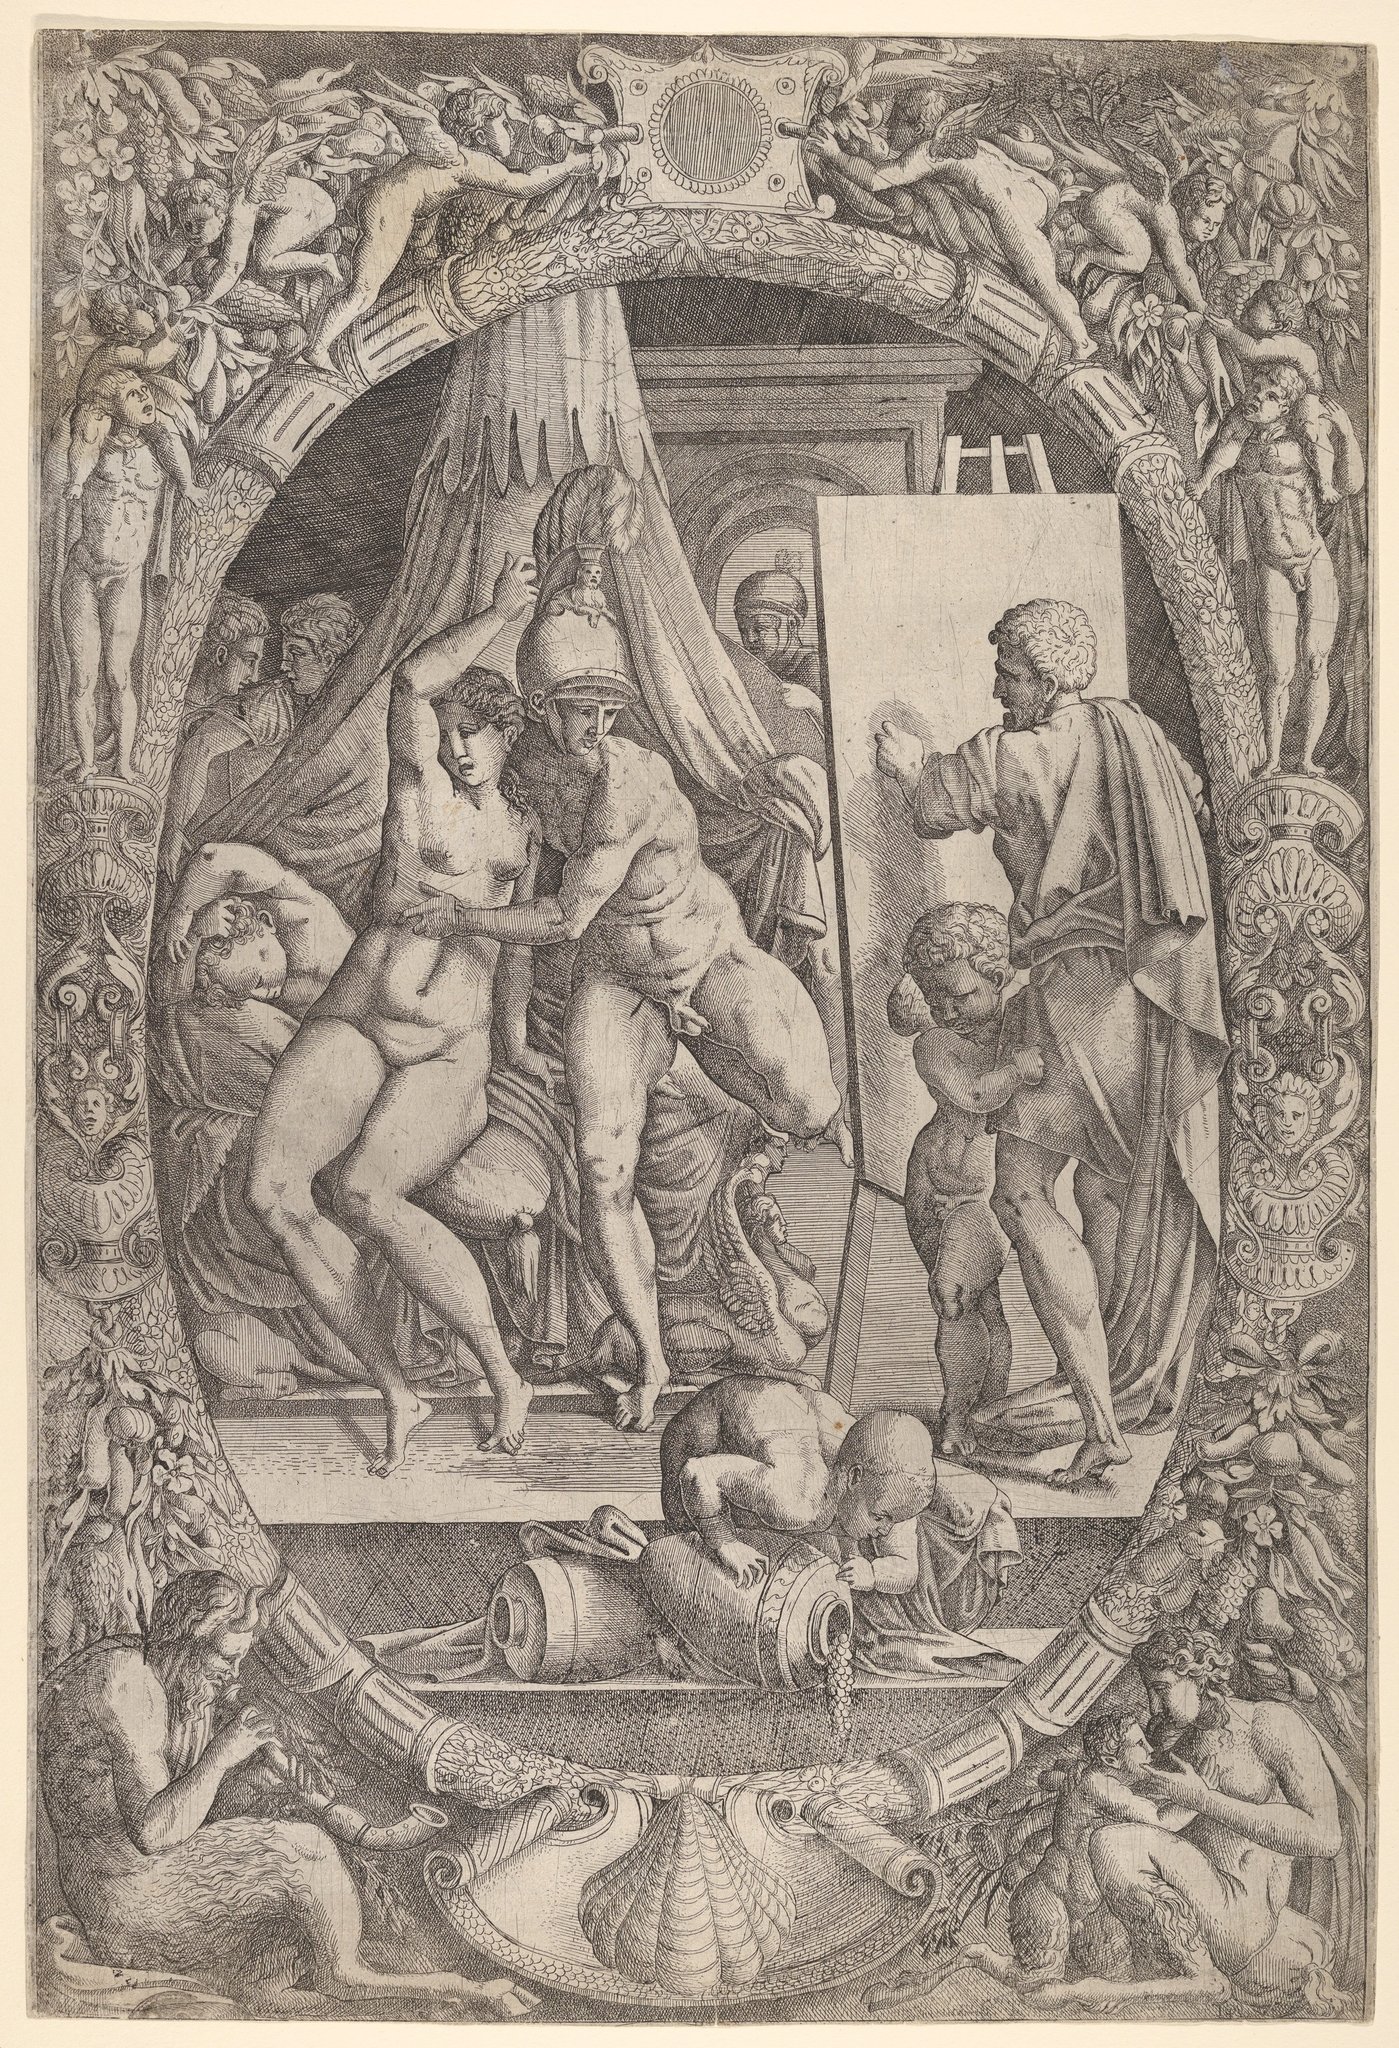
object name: print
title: Apelles Painting Alexander and Campaspe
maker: master iqv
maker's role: artist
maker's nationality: french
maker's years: 1500-1600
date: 1525-1575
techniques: etching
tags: painting,alexander the great,male nudes,female nudes